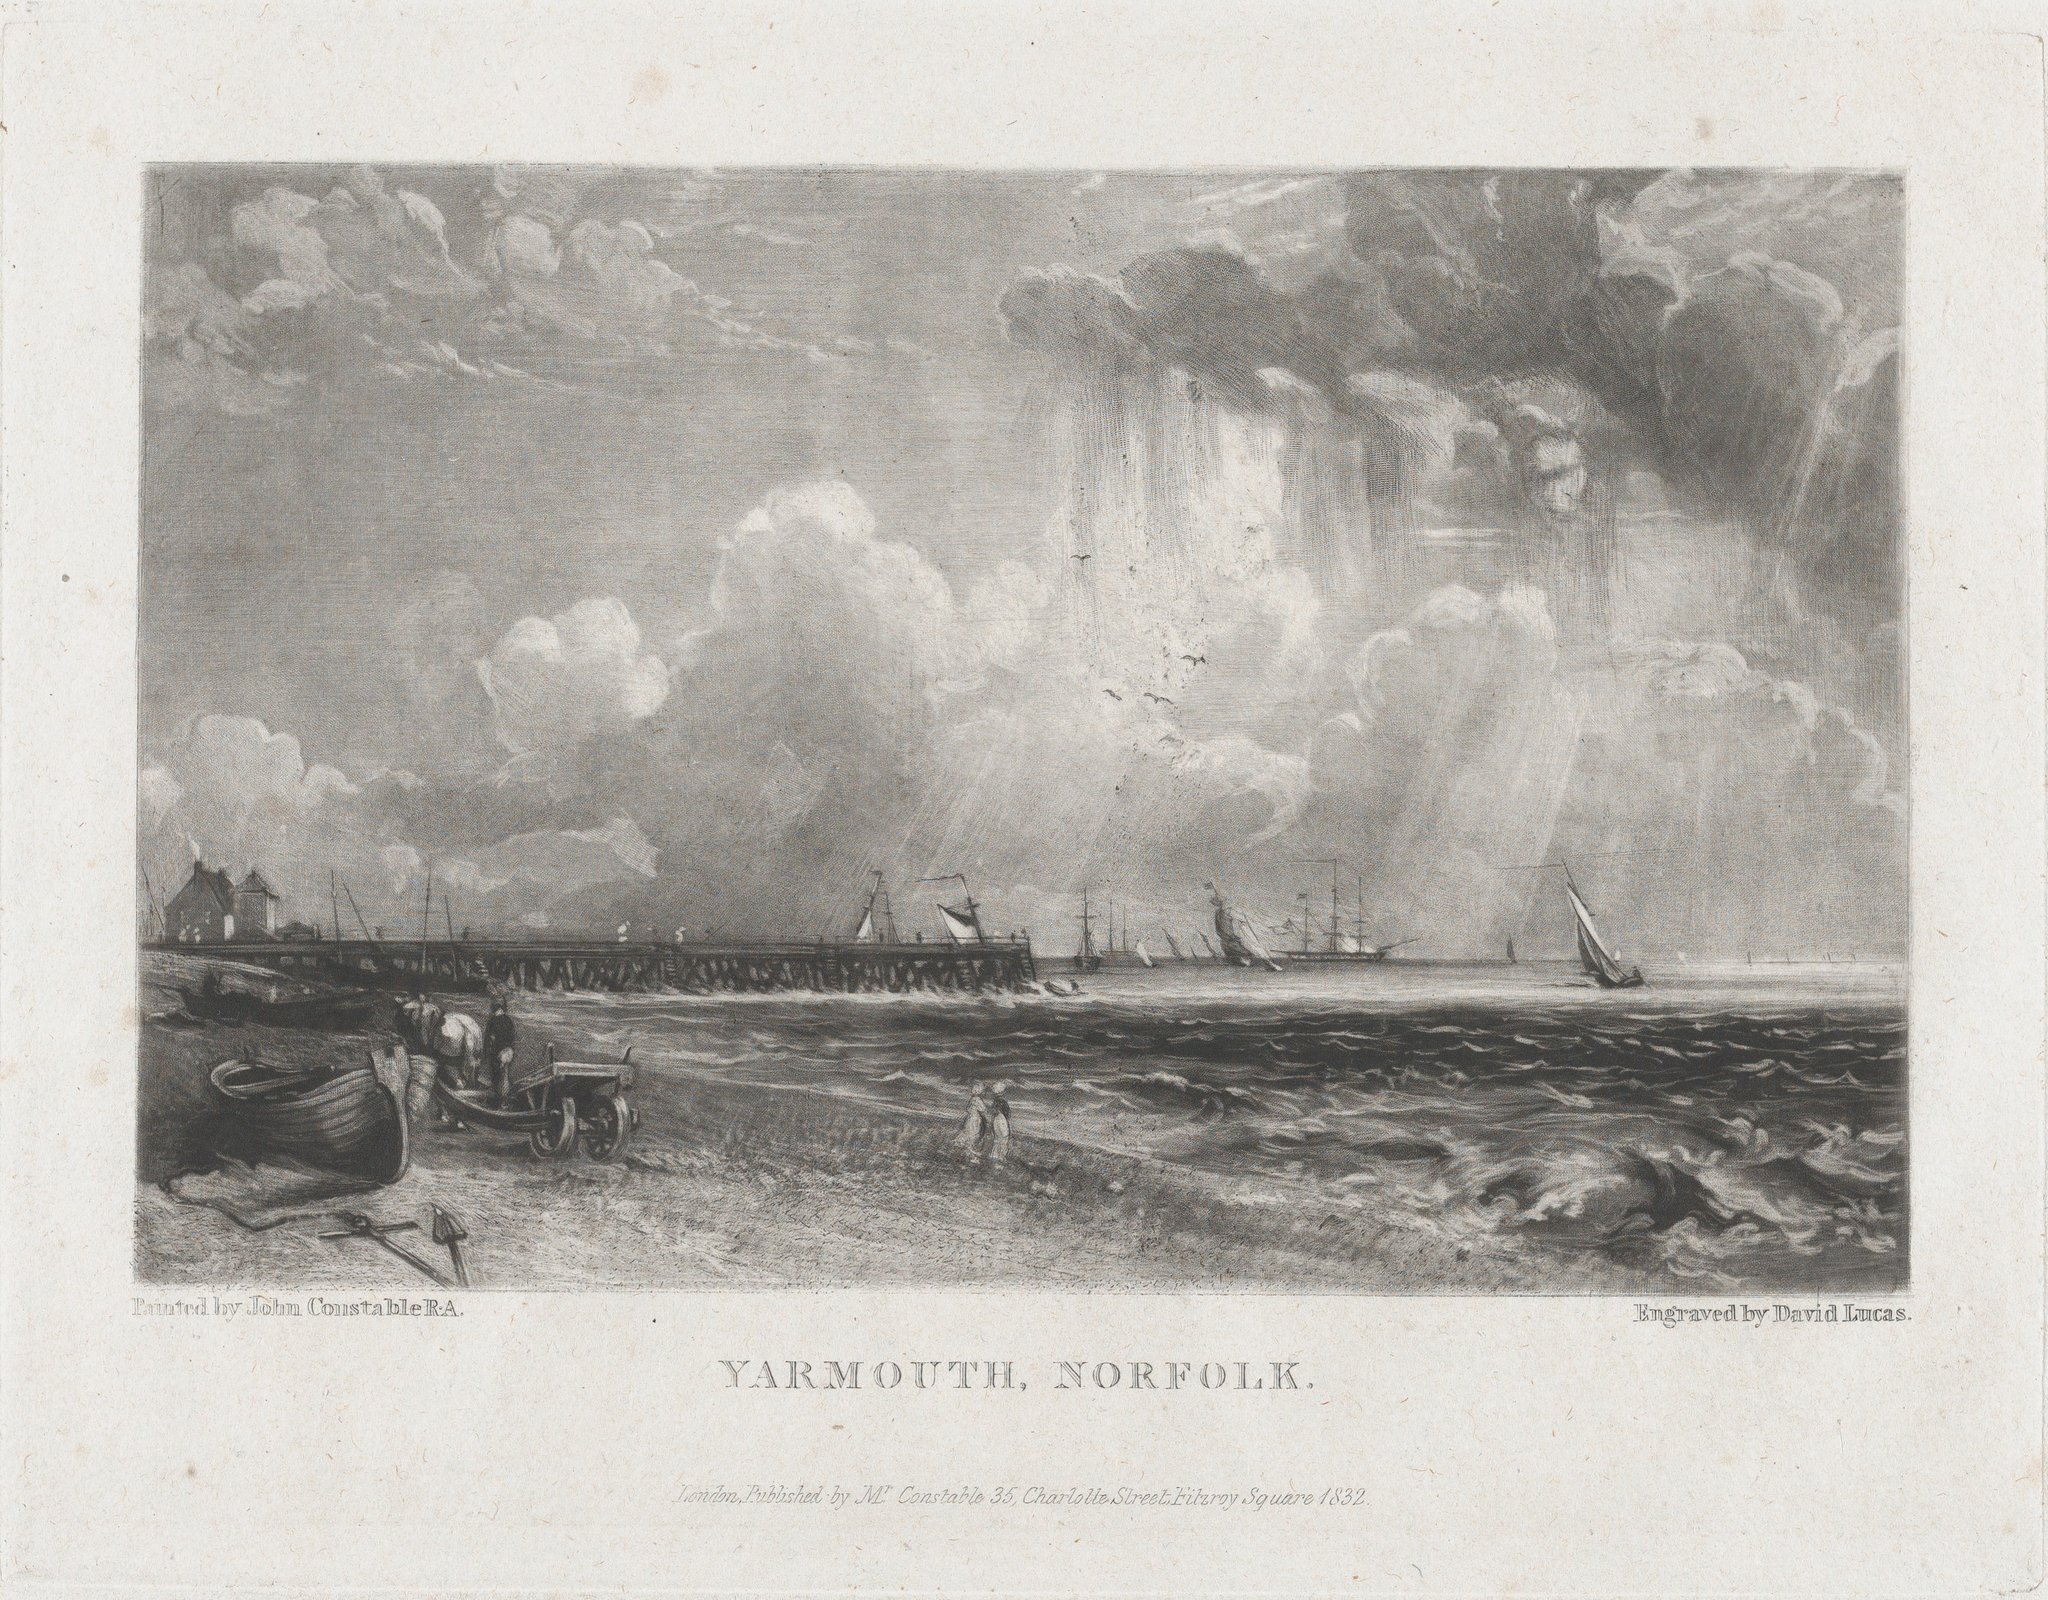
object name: print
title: Yarmouth, Norfolk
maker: david lucas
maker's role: artist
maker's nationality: british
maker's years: 1802-1881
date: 1832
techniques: mezzotint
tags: seascapes,boats,piers